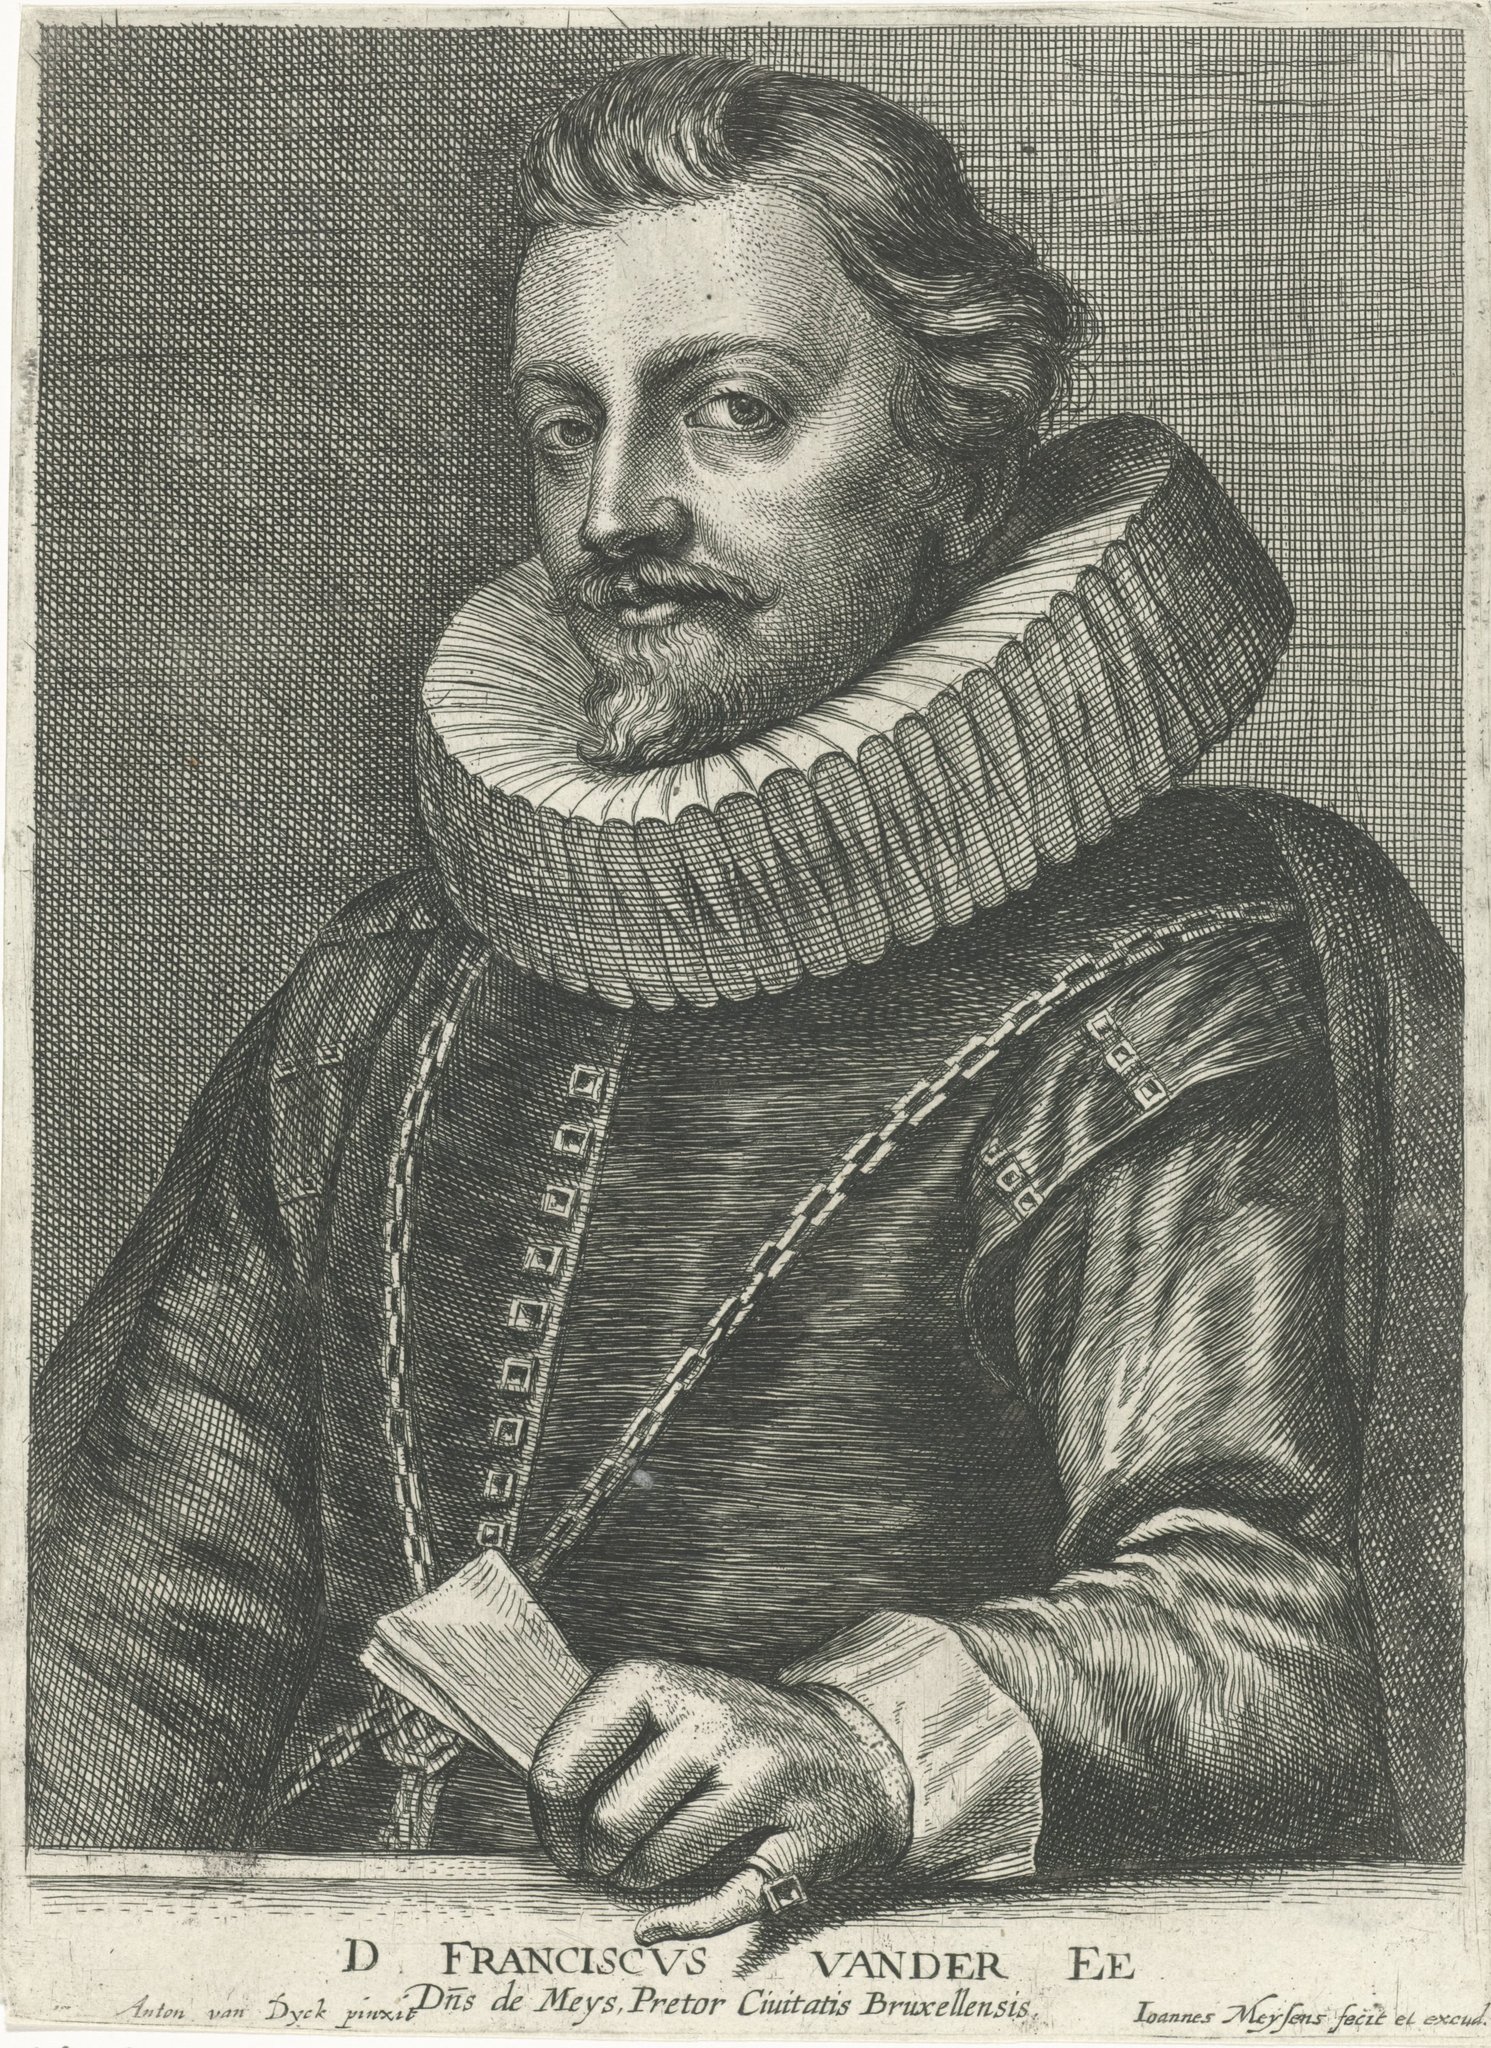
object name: print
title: Portret van Franciscus van der Ee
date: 1640-1670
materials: paper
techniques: engraving, etching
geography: antwerp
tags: françois van der ee, bailiff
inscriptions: collector's mark: Lugt 240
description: Portret van Franciscus van der Ee, amman (baljuw) van Brussel. Aan zijn pink een ring.